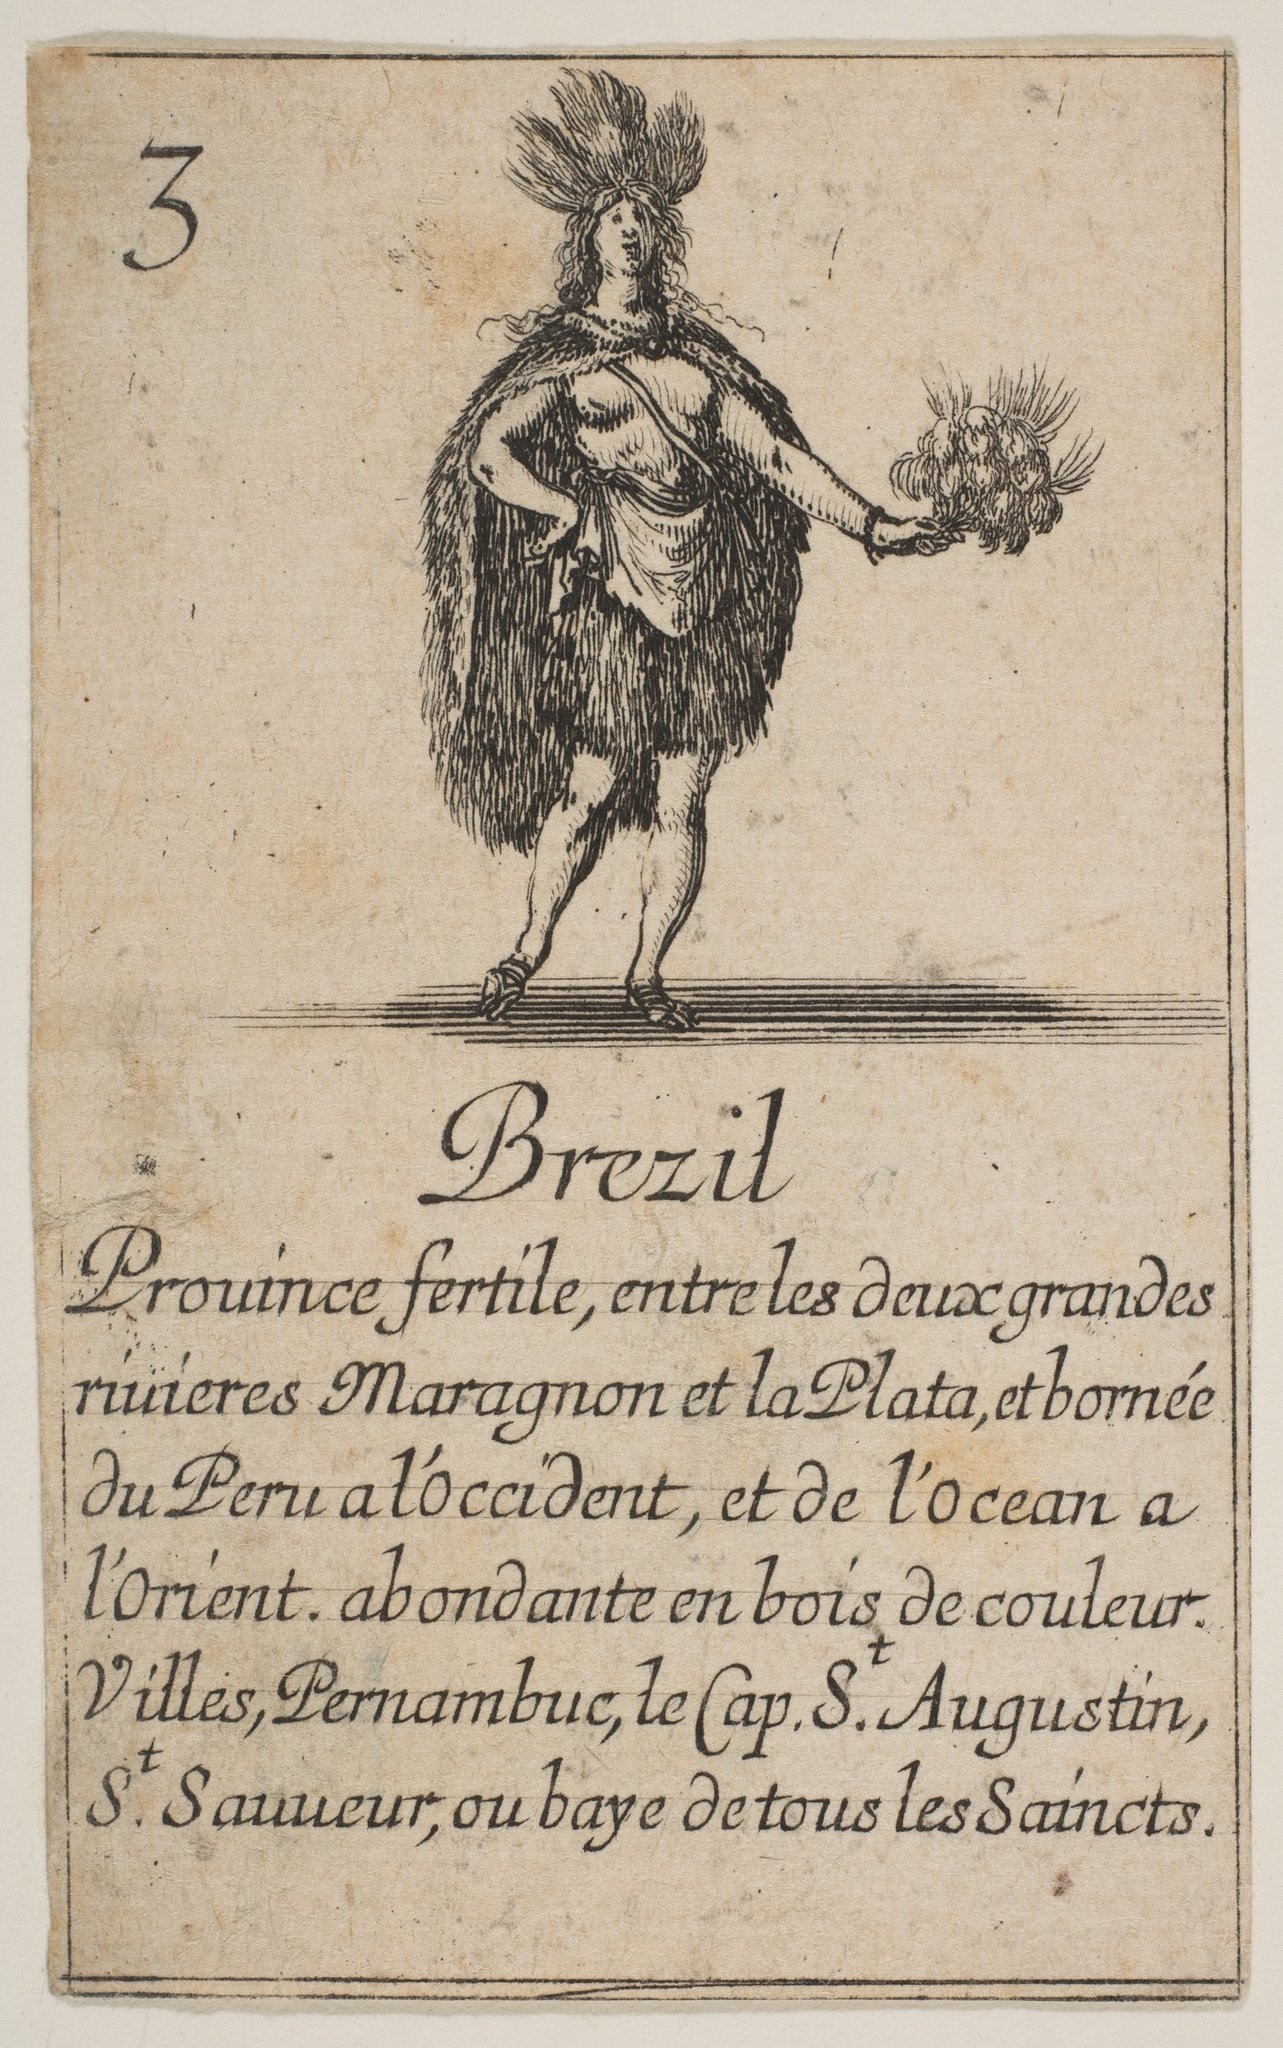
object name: print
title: Brazil, from the playing cards "Jeu de la Géographie"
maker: stefano della bella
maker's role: artist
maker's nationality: italian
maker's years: 1610-1664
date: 1644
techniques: etching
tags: men